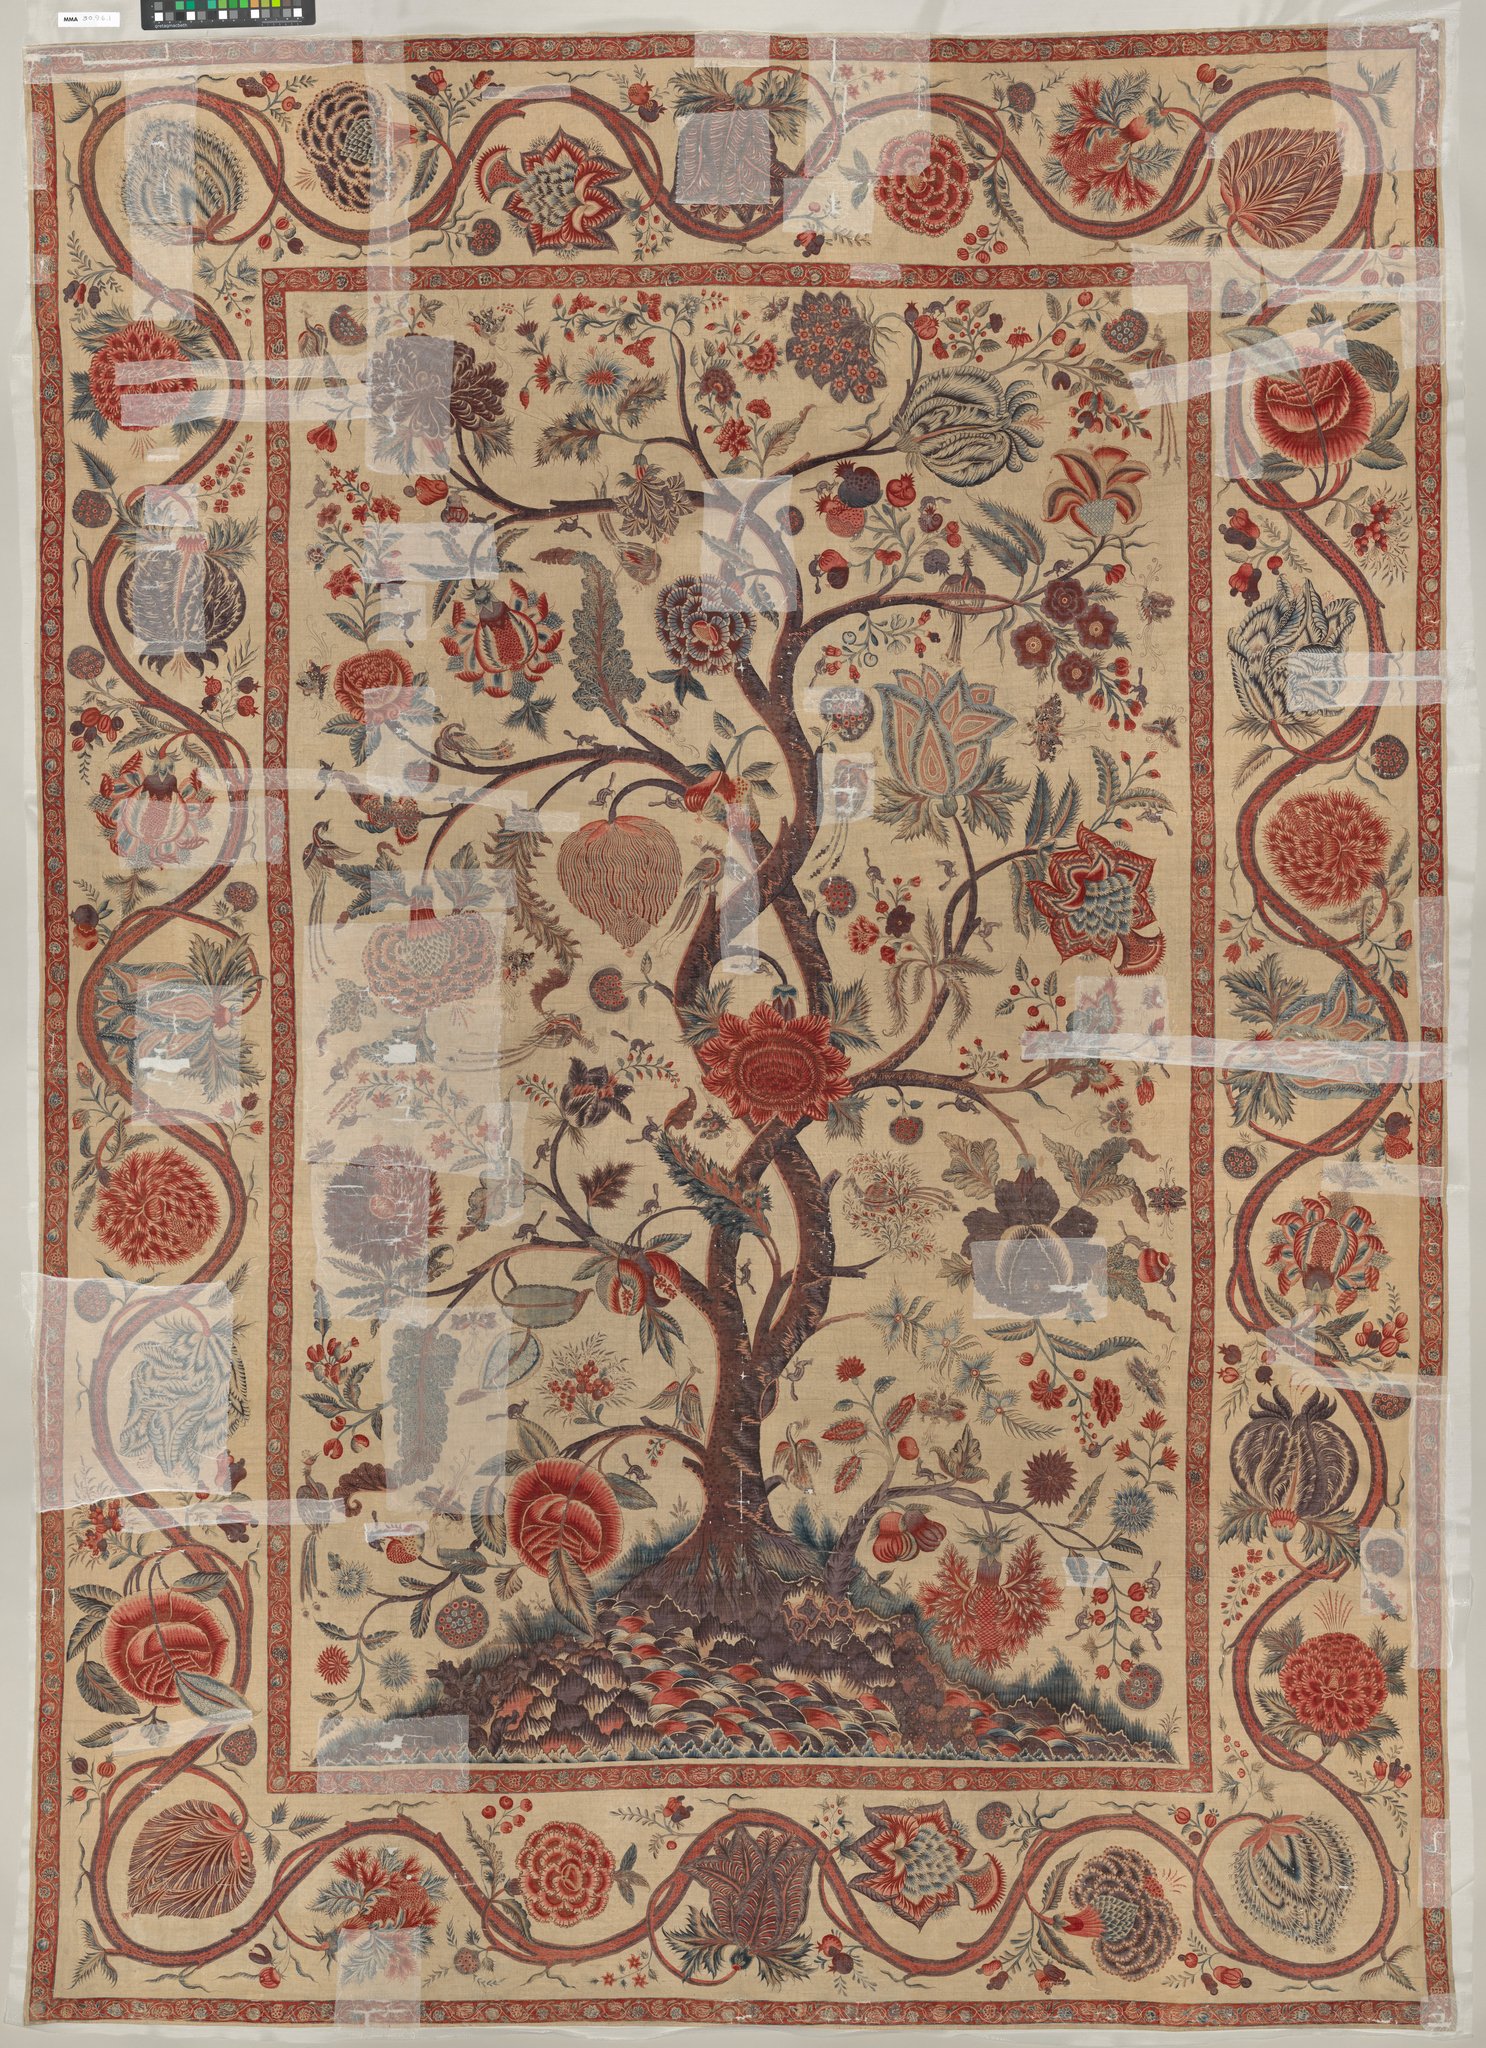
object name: hanging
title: Hanging (Palampore)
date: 1667-1700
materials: cotton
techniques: painting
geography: india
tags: flowers,trees